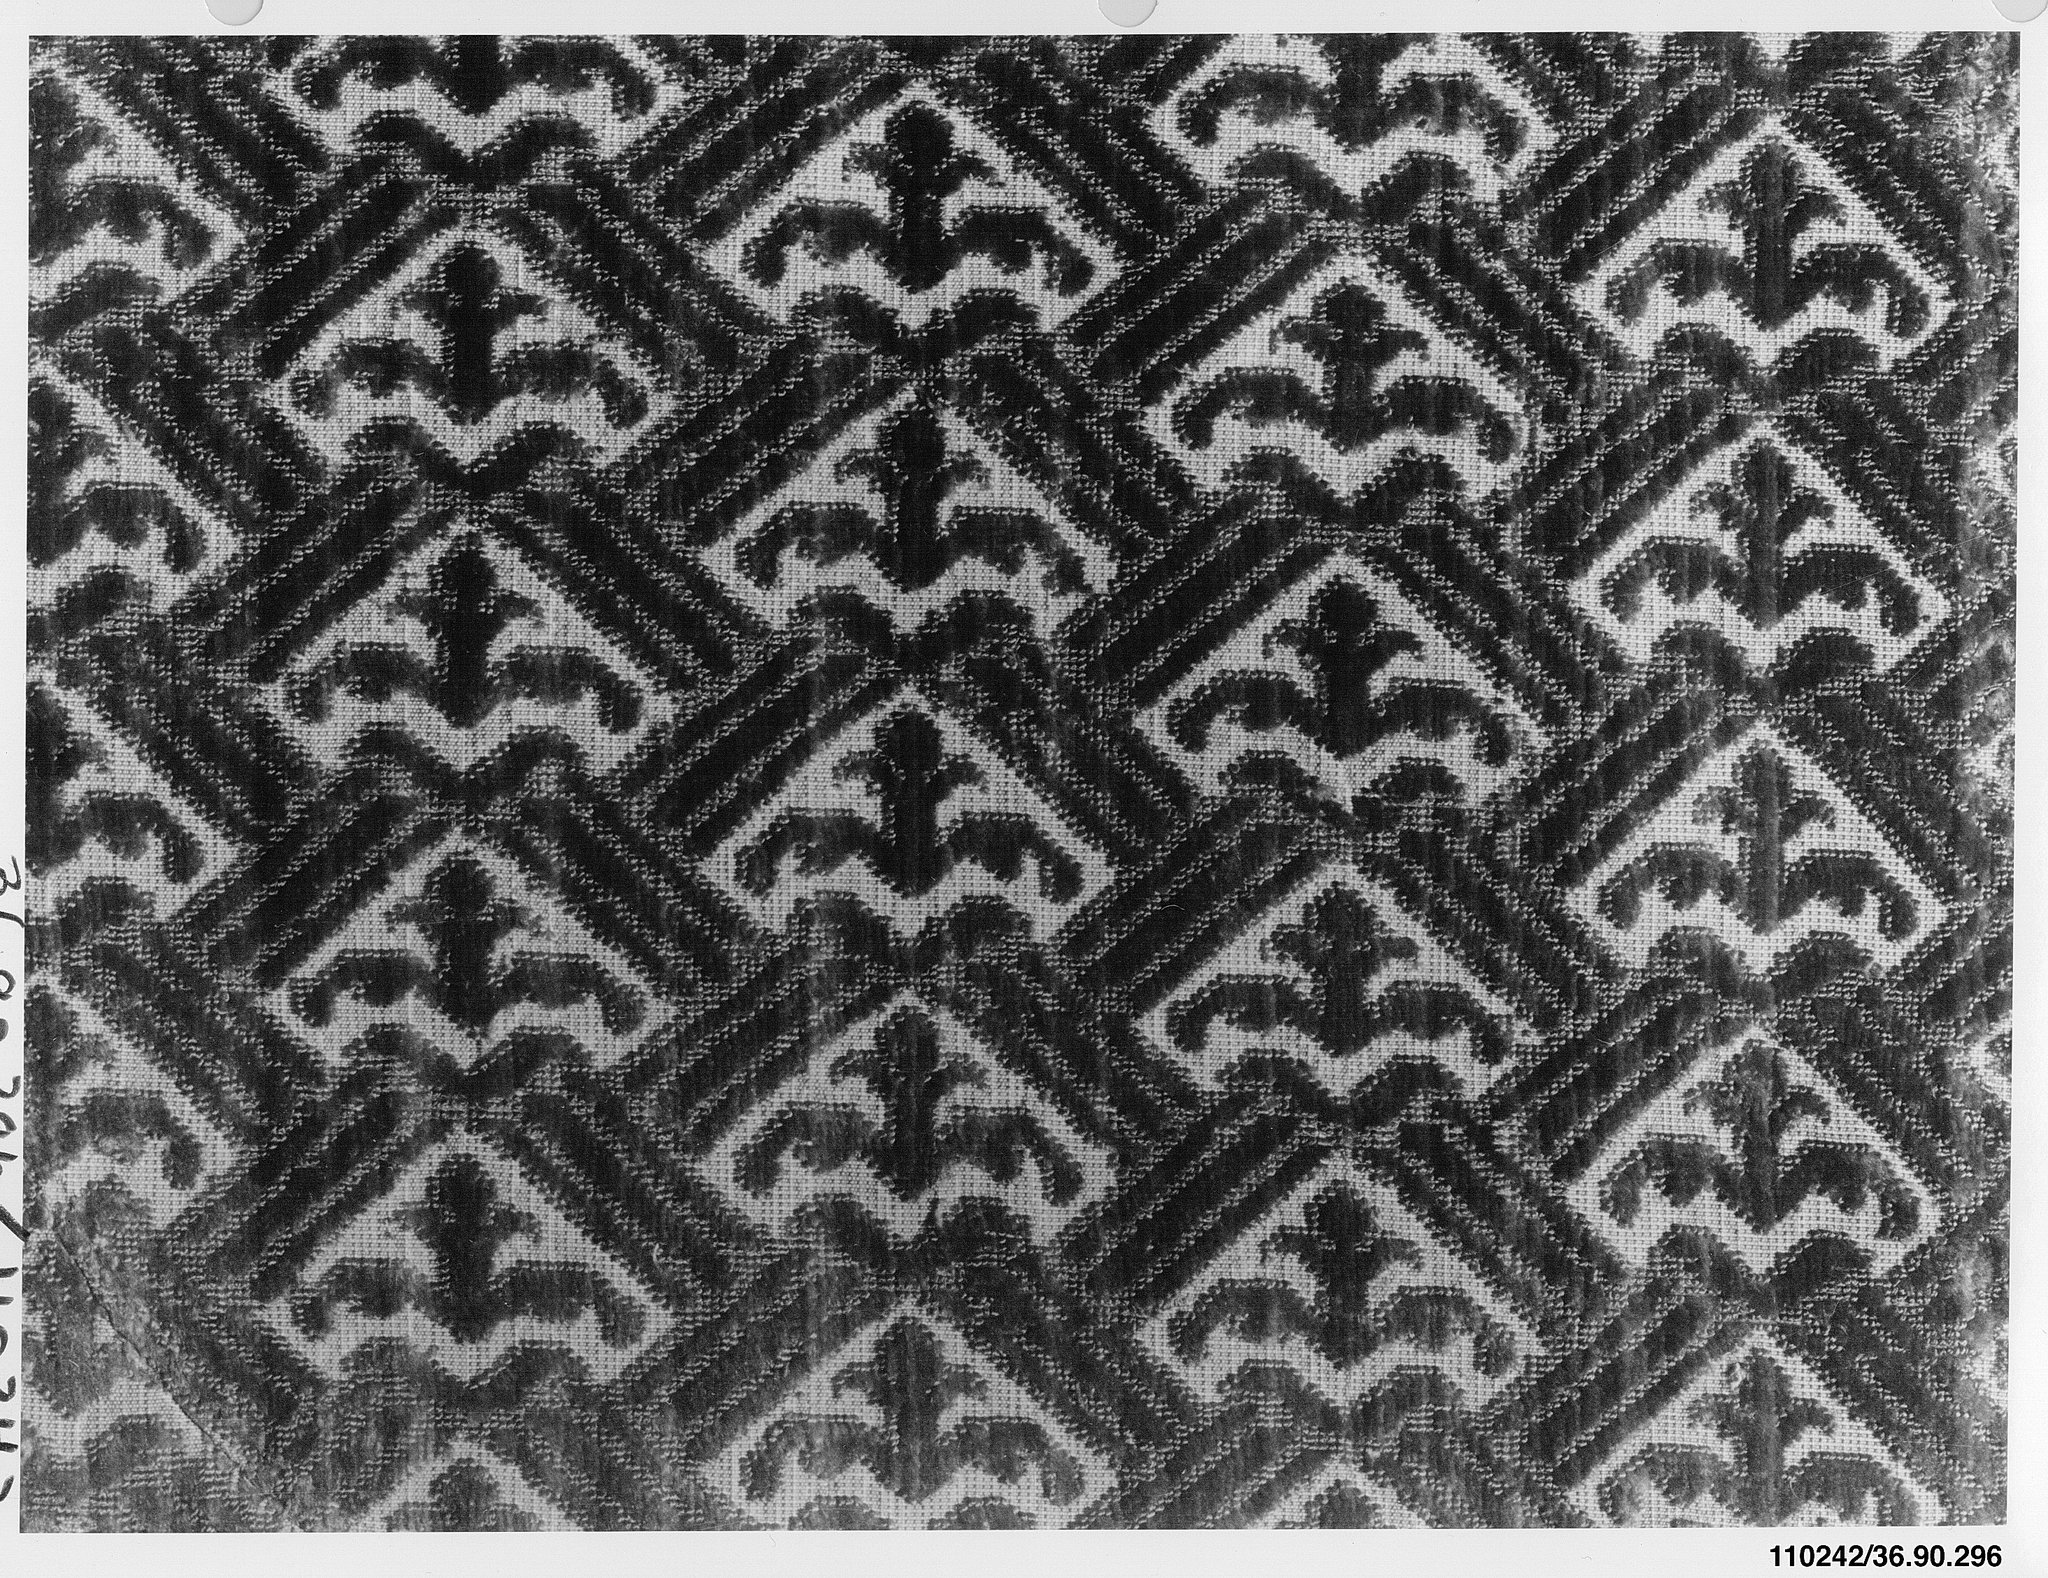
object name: piece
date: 1501-1700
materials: silk